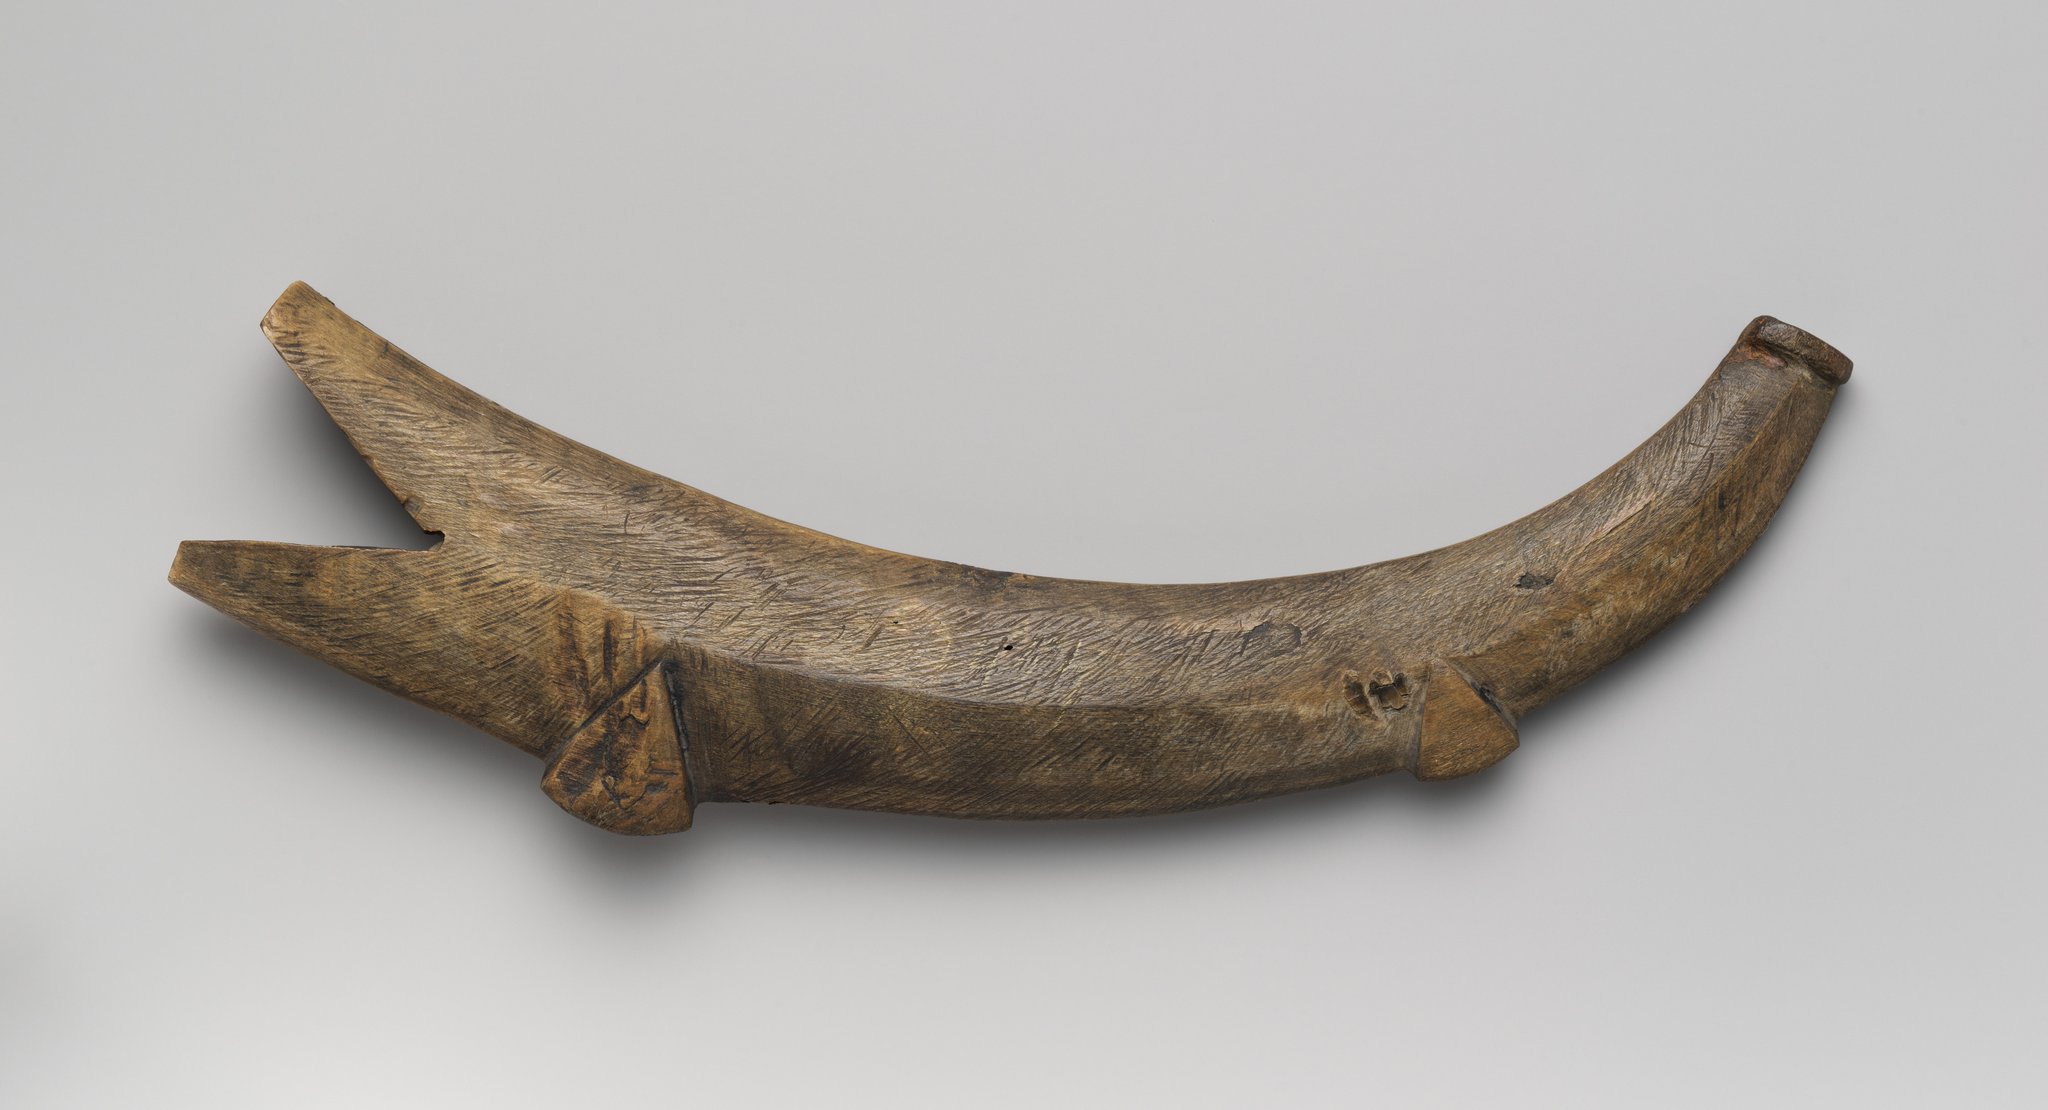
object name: nafir or muzmar el daraweesh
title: Nafir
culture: iranian or persian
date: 1867-1900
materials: horn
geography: iran